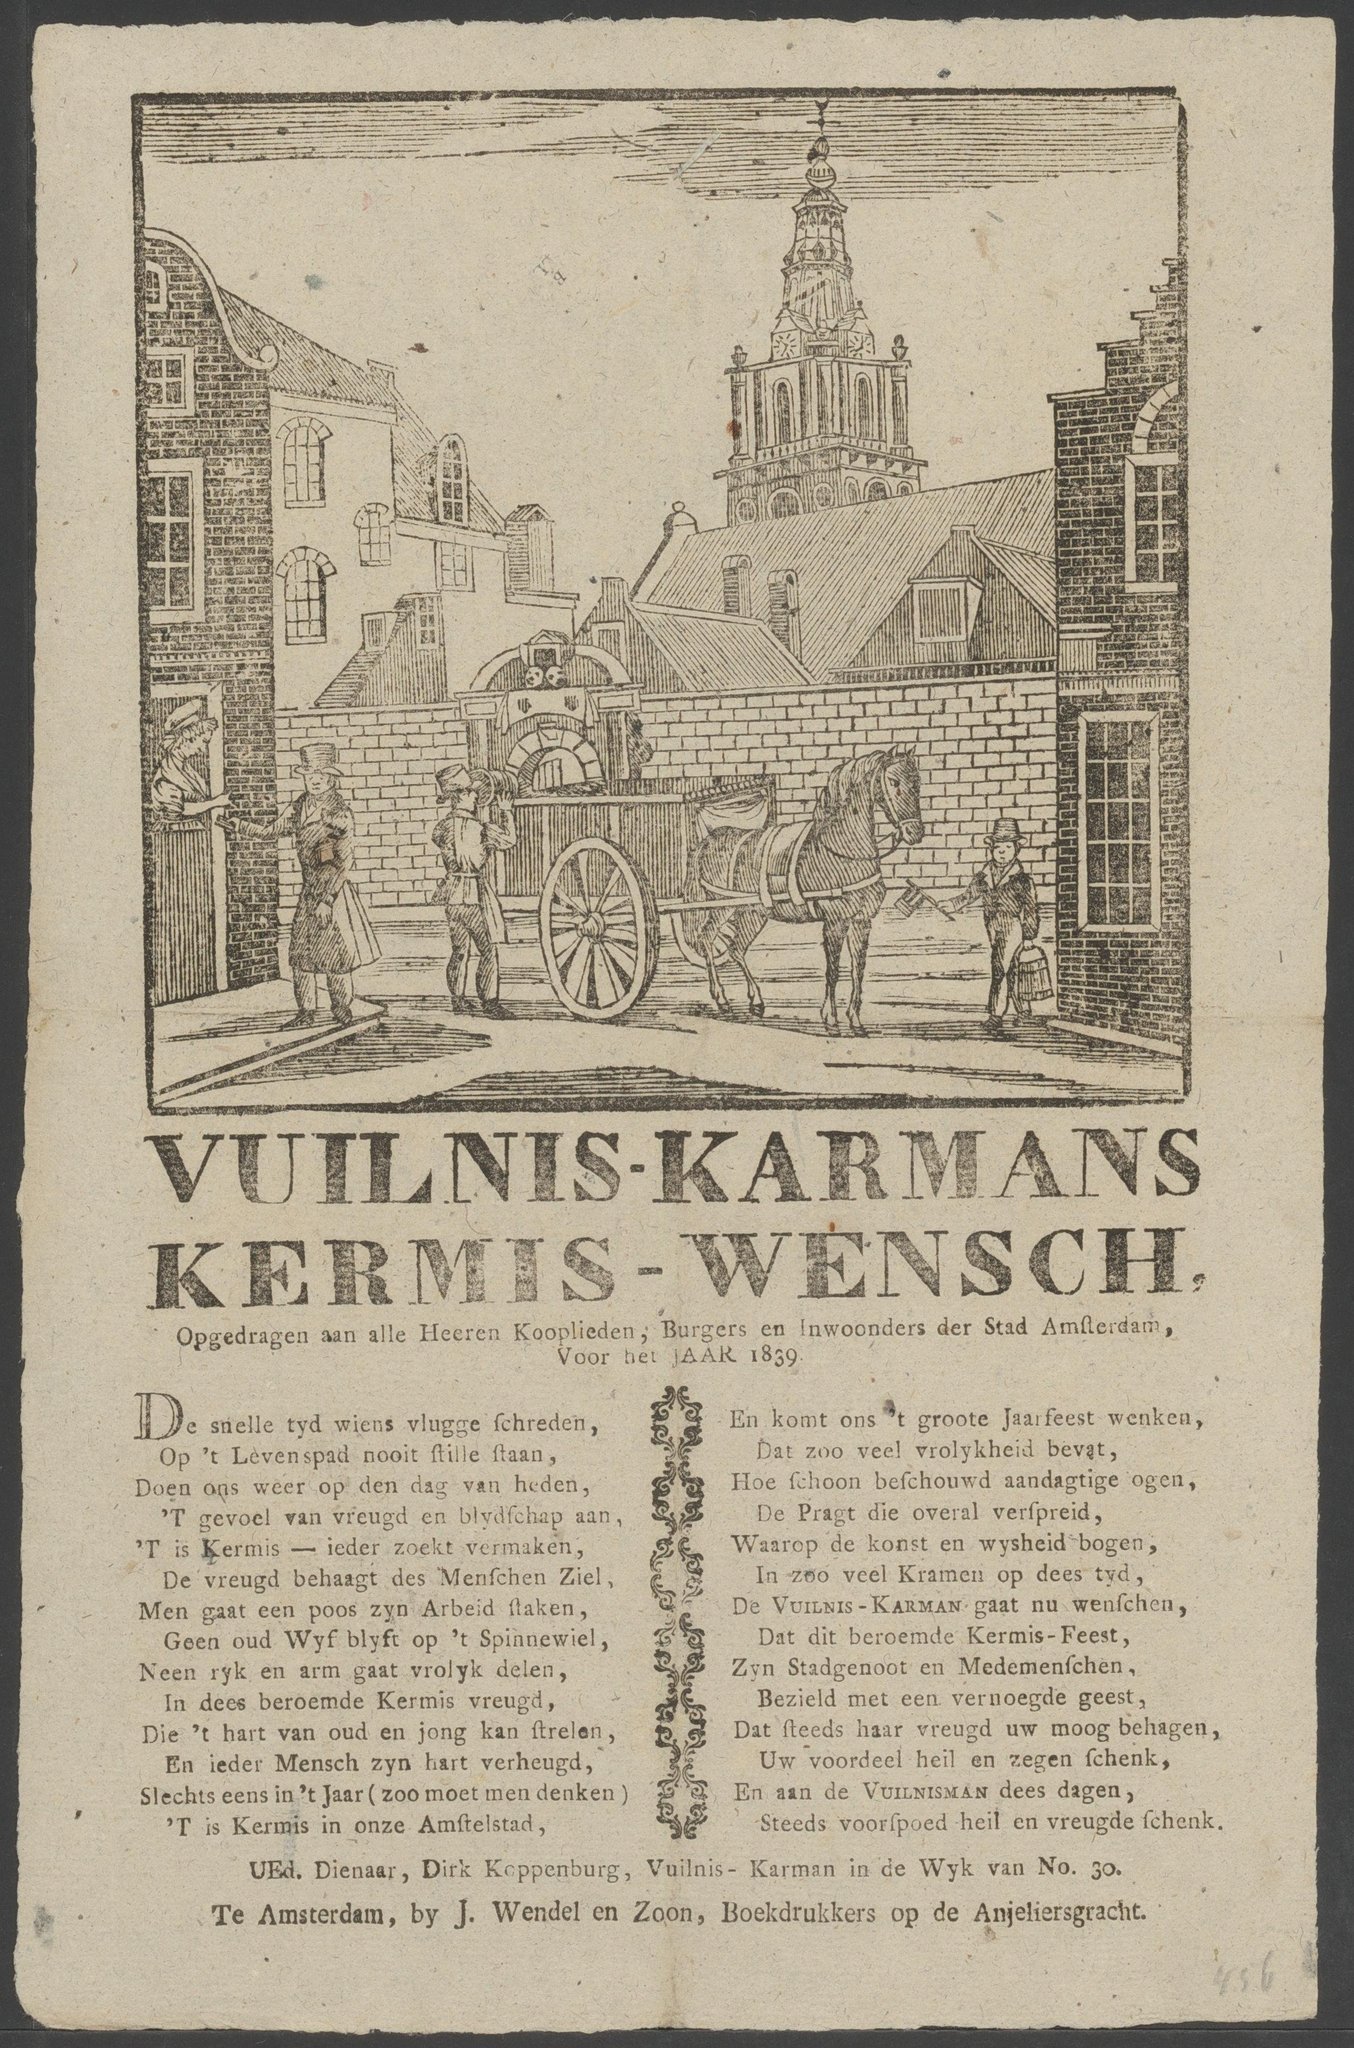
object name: print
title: Vuilnis-Karmans Kermis-wensch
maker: Anonymous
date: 1839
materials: paper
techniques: letterpress printing, engraving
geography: amsterdam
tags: street, garbage collection, amsterdam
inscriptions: watermark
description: Kermisprent van de Amsterdamse vuilnismannen voor het jaar 1839. Gezicht bij de Sint-Antoniesbreestraat en het poortje naar de Zuiderkerkhof bij de Zuiderkerk te Amsterdam, waar een man een vuilnisemmer in de kar omkeert en een andere man met de ratel draait. Een andere man haalt bij een huis geld op. Met gedicht in twee kolommen. Van de vuilniskarman in de wijk no. 30: Dirk Koppenburg. Onderwerpsrubrieken binnen de Atlas Zeden en Gewoonten: Zeden en gewoonten in engeren zin, Volksleven, Volksbladen, Nieuwjaars- en Kerstwenschen, Amsterdam.